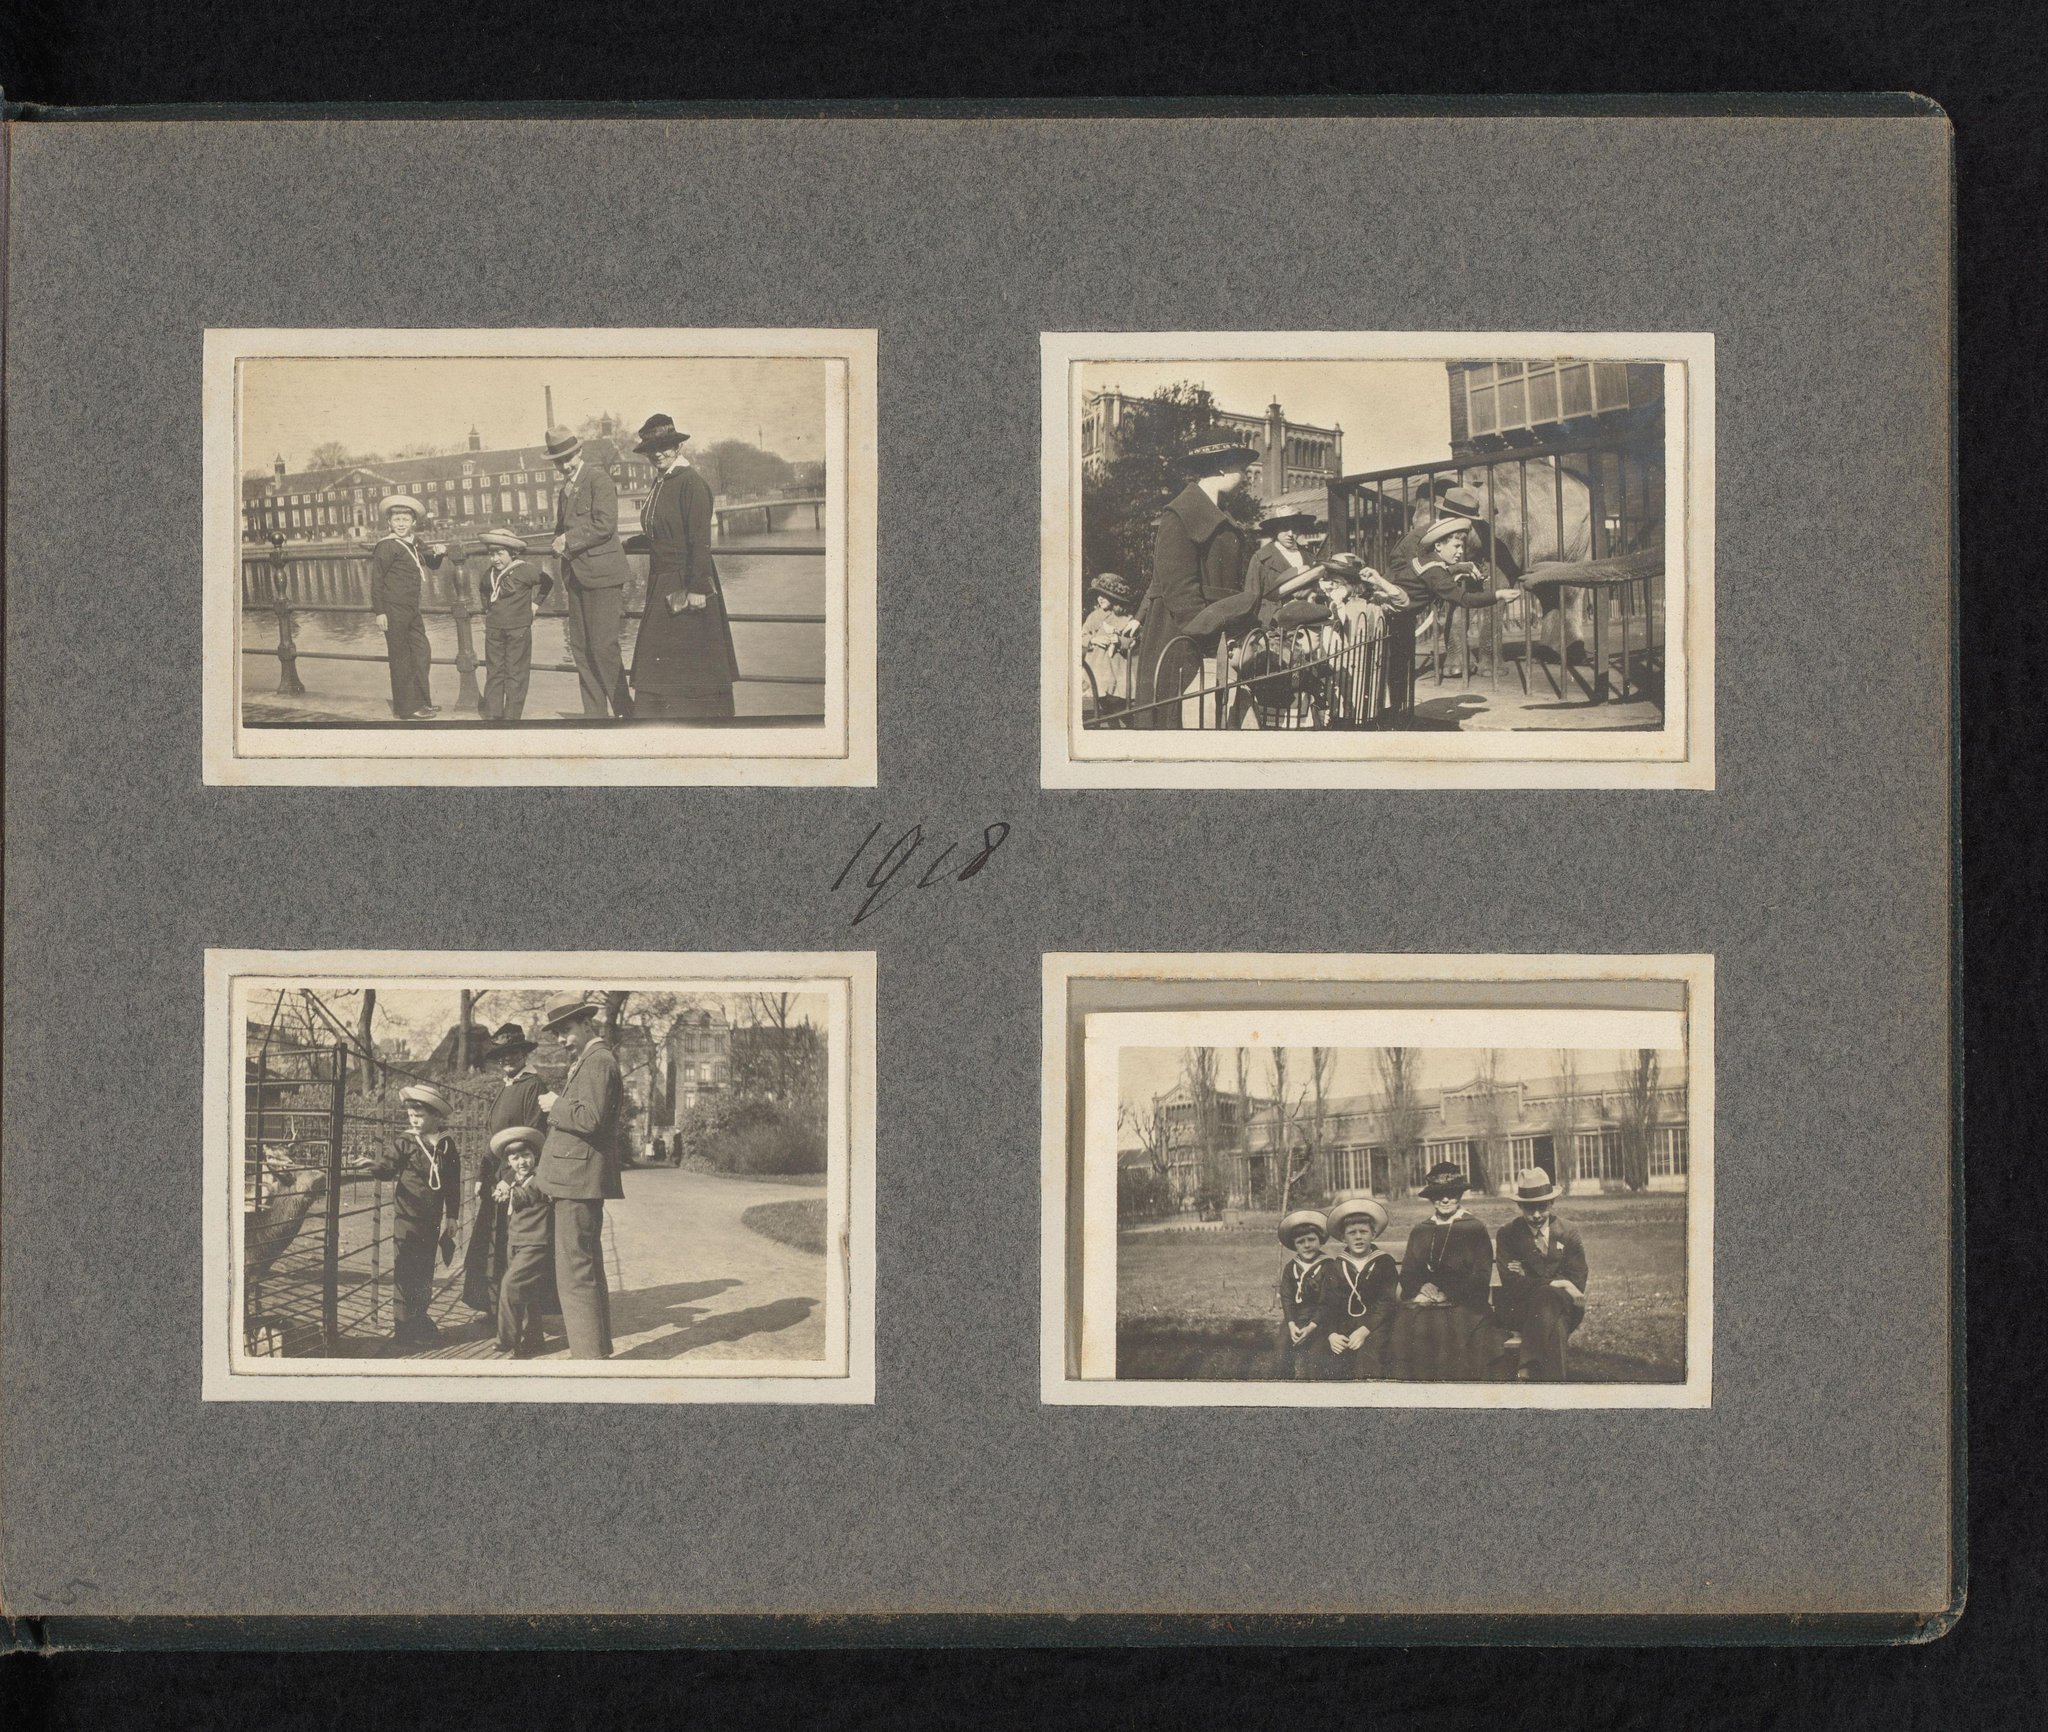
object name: photograph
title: Caroline, Carel en Frank van den Berg in Artis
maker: hendrik herman van den berg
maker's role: amateurfotograaf, jurist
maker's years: 1875-1944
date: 1918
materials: paper, cardboard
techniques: gelatin silver print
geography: amsterdam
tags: the hague, caroline louise van den berg-van den berg, carel frederik van den berg (cay), frank willem van den berg (1912-1998), zoo (as place of recreation)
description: Deze foto's zijn onderdeel van een album.